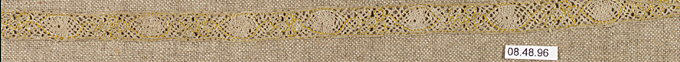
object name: insertion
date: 1801-1900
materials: silk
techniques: lace